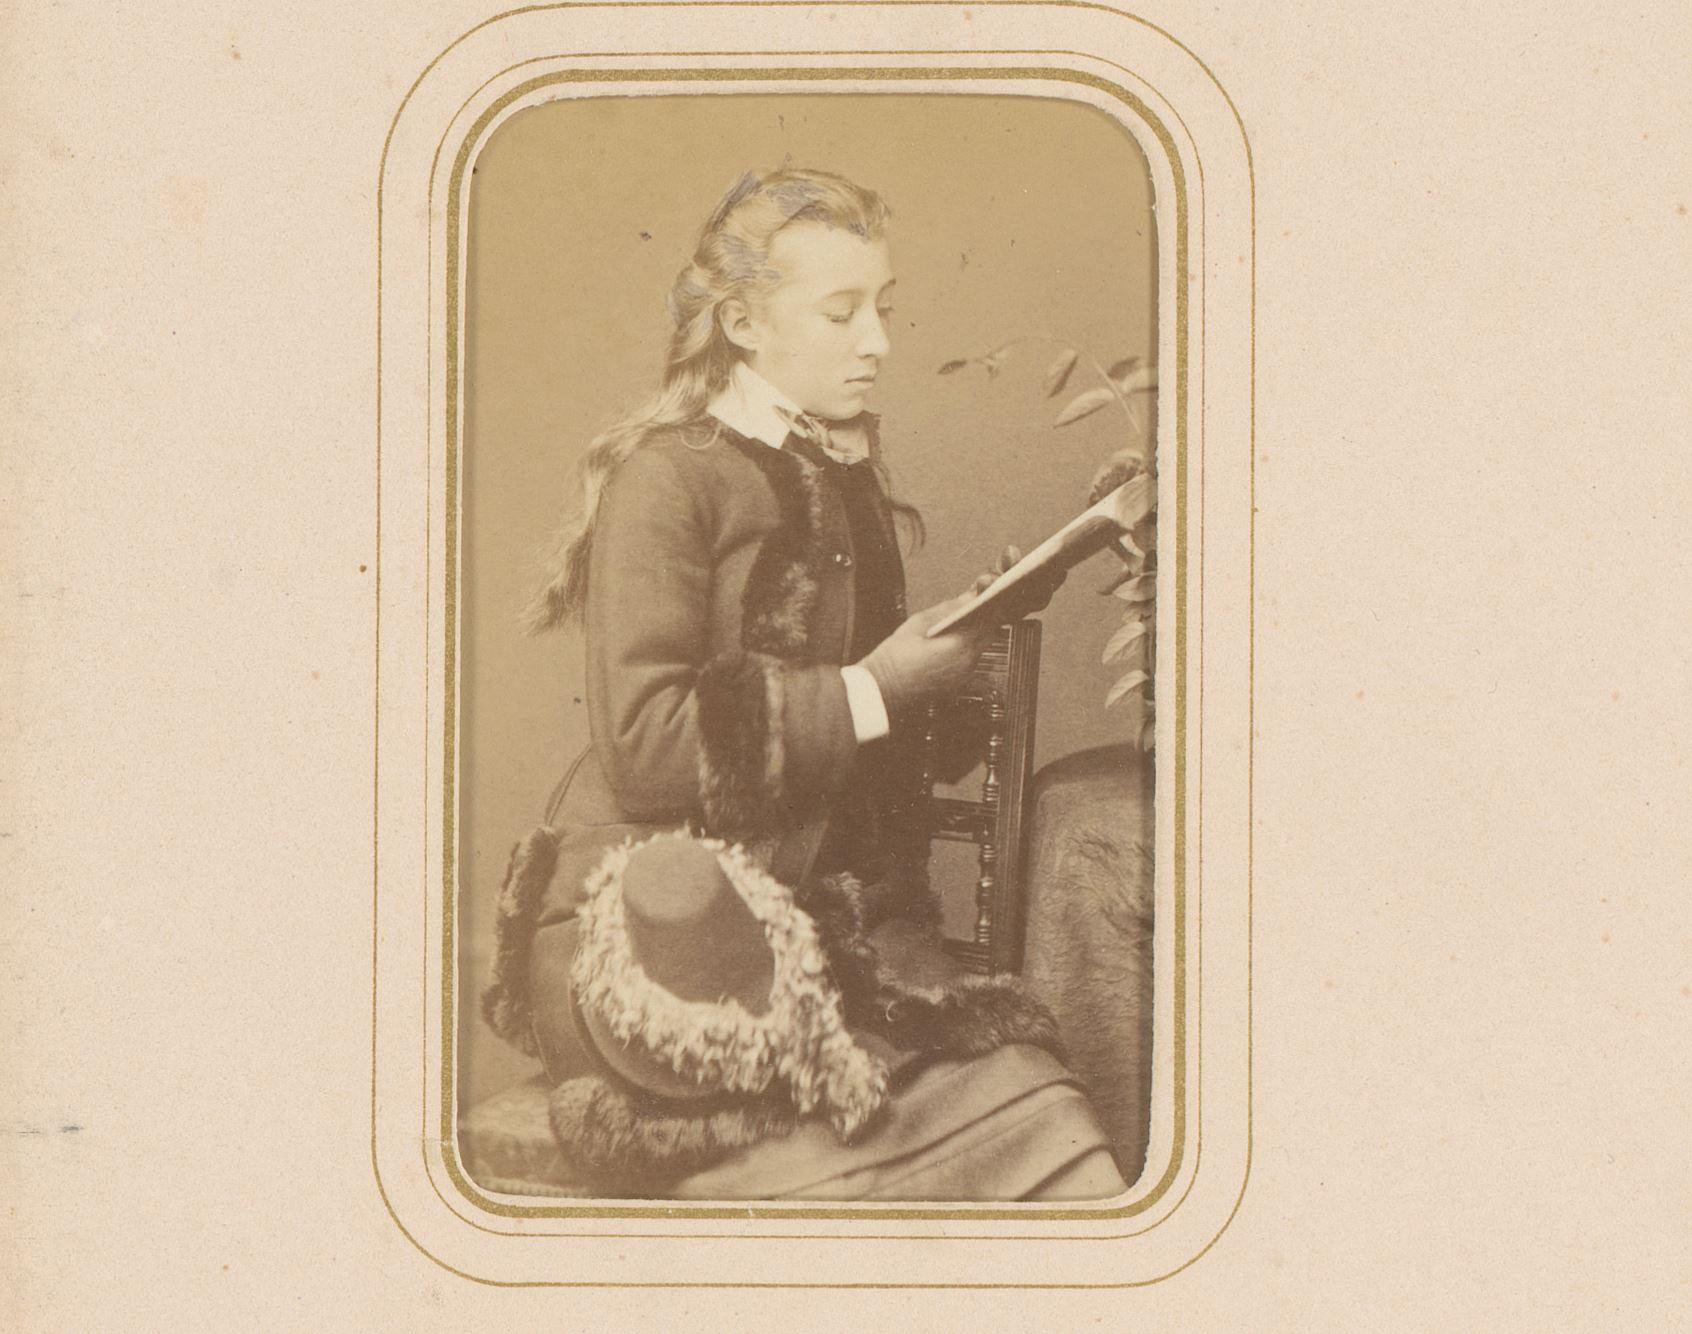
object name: photograph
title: Portret van een lezend meisje, zittend op een stoel met een hoed op schoot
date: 1860-1880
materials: cardboard, photographic support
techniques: albumen print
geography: london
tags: reading, sitting figure - aa - female human figure, historical persons - bb - woman, girl (child between toddler and youth), head-gear: hat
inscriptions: inscription: ‘Elliott & Fry/ Photographers/ 55, Baker Street, London/ w./ No. 110664’